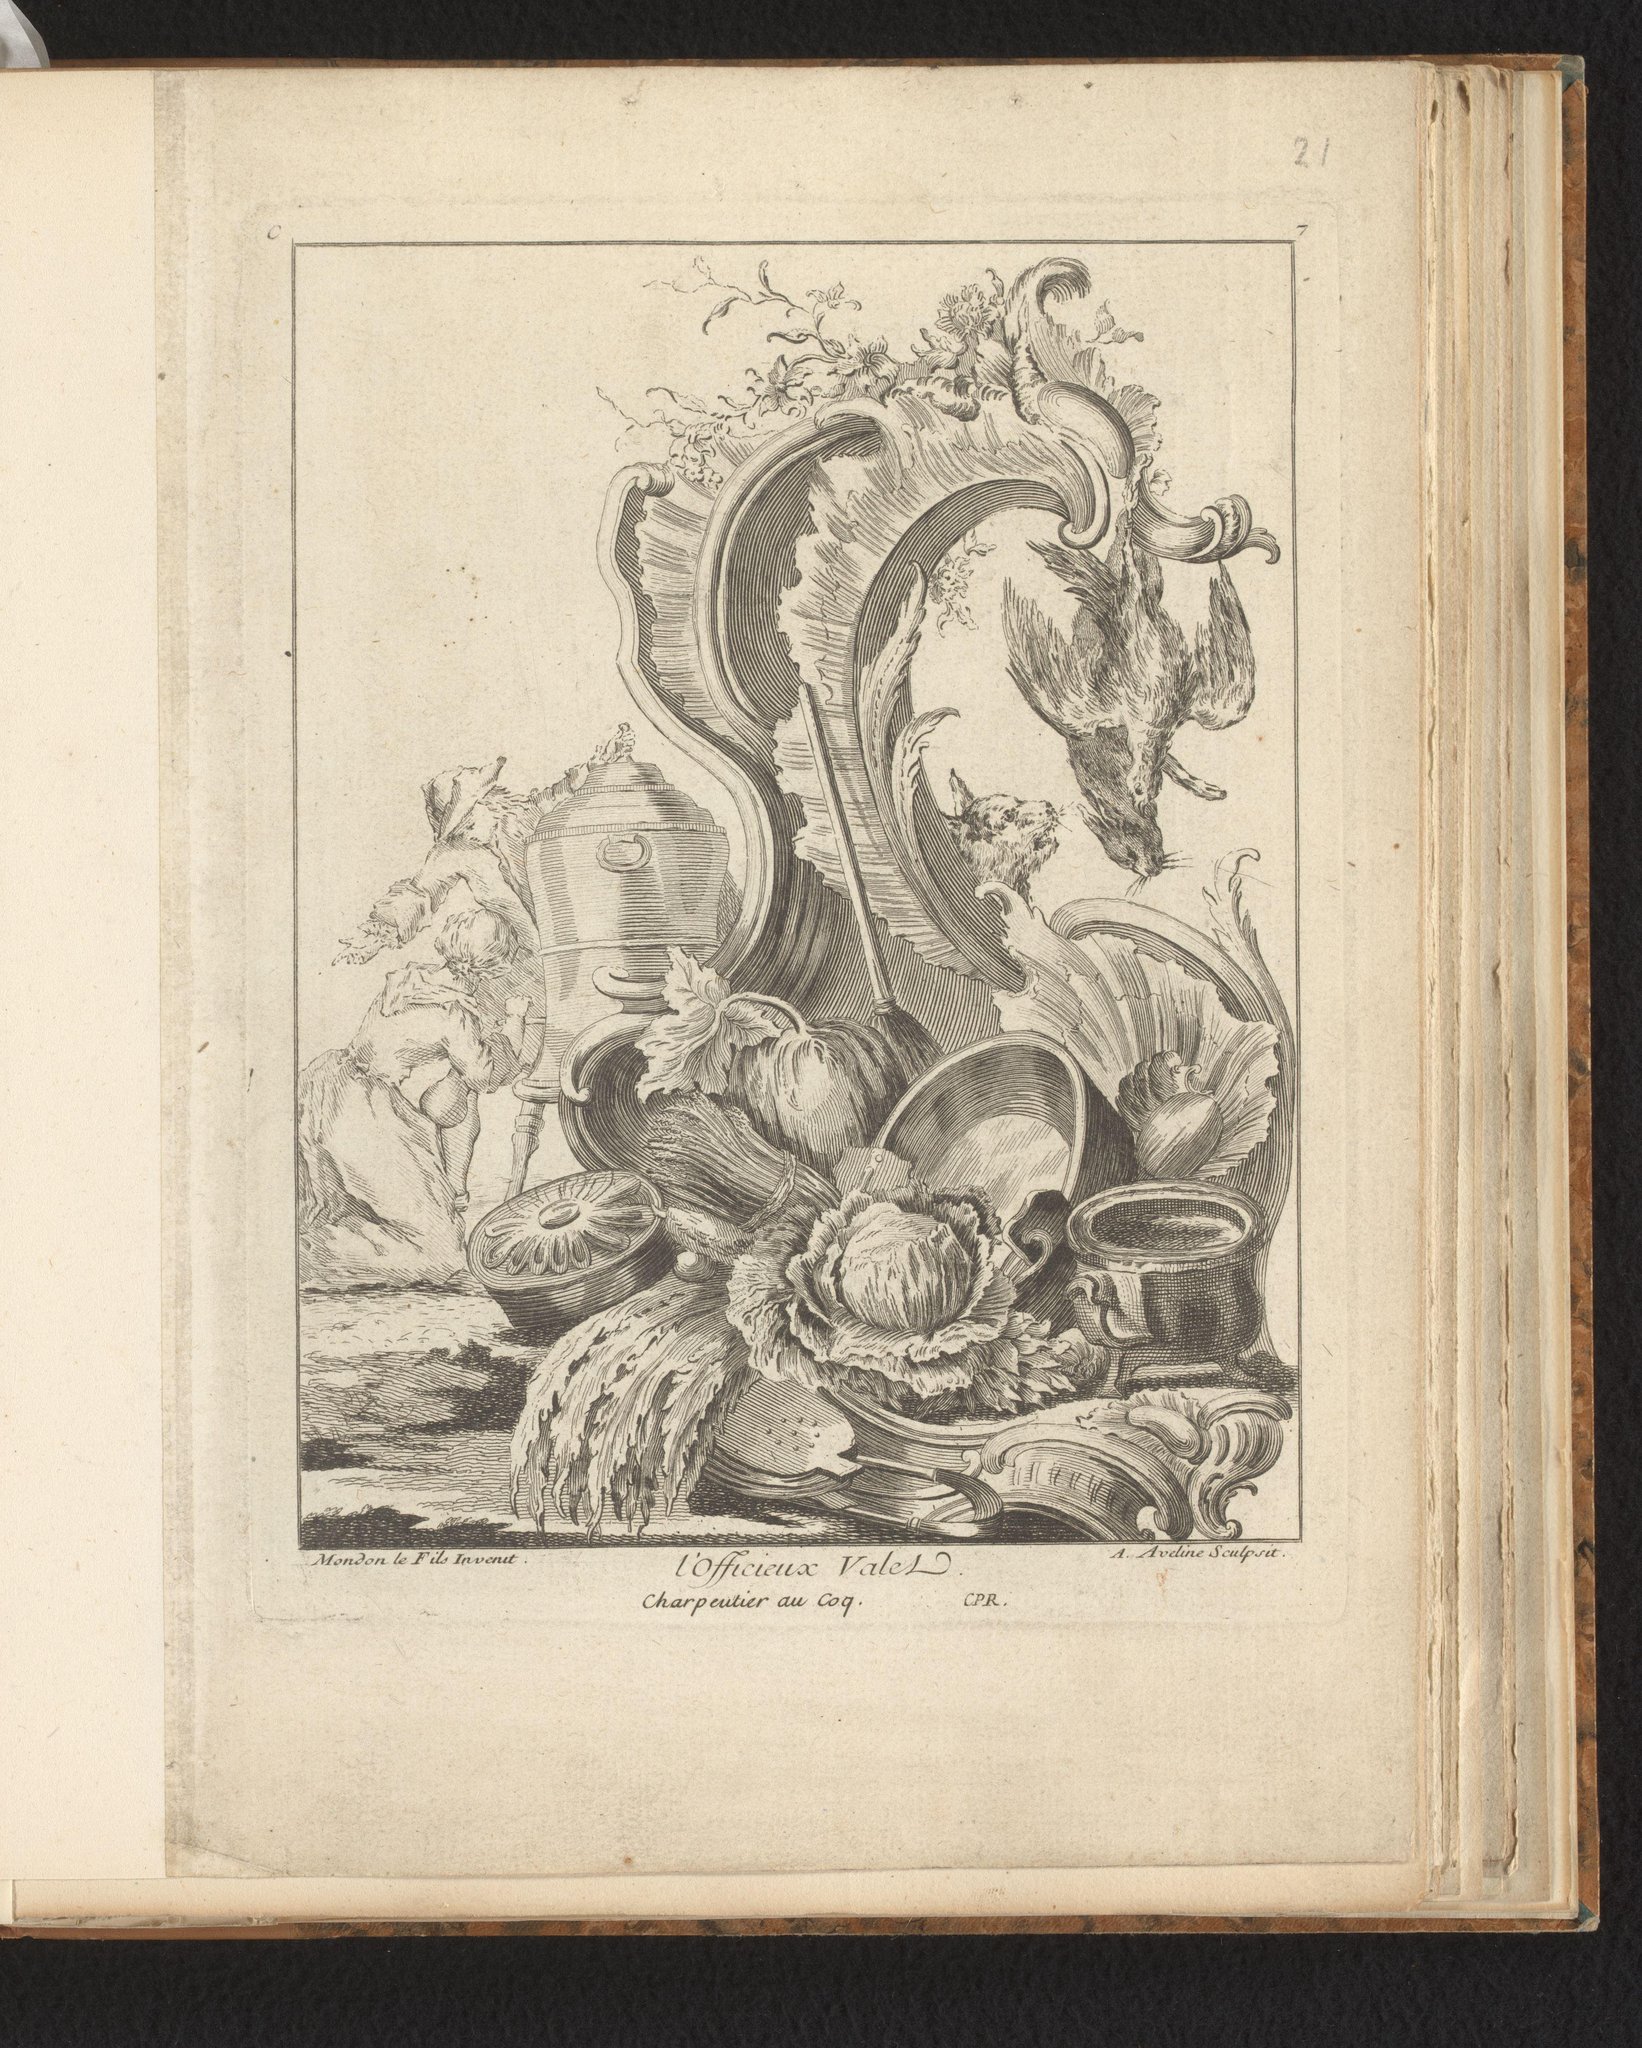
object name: print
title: L'Officieux Valet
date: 1736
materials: paper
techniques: engraving, etching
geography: france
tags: kitchen-utensils, rocaille ornament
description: Deze serie is linksboven genummerd met een letter C. Prent maakt deel uit van een album.